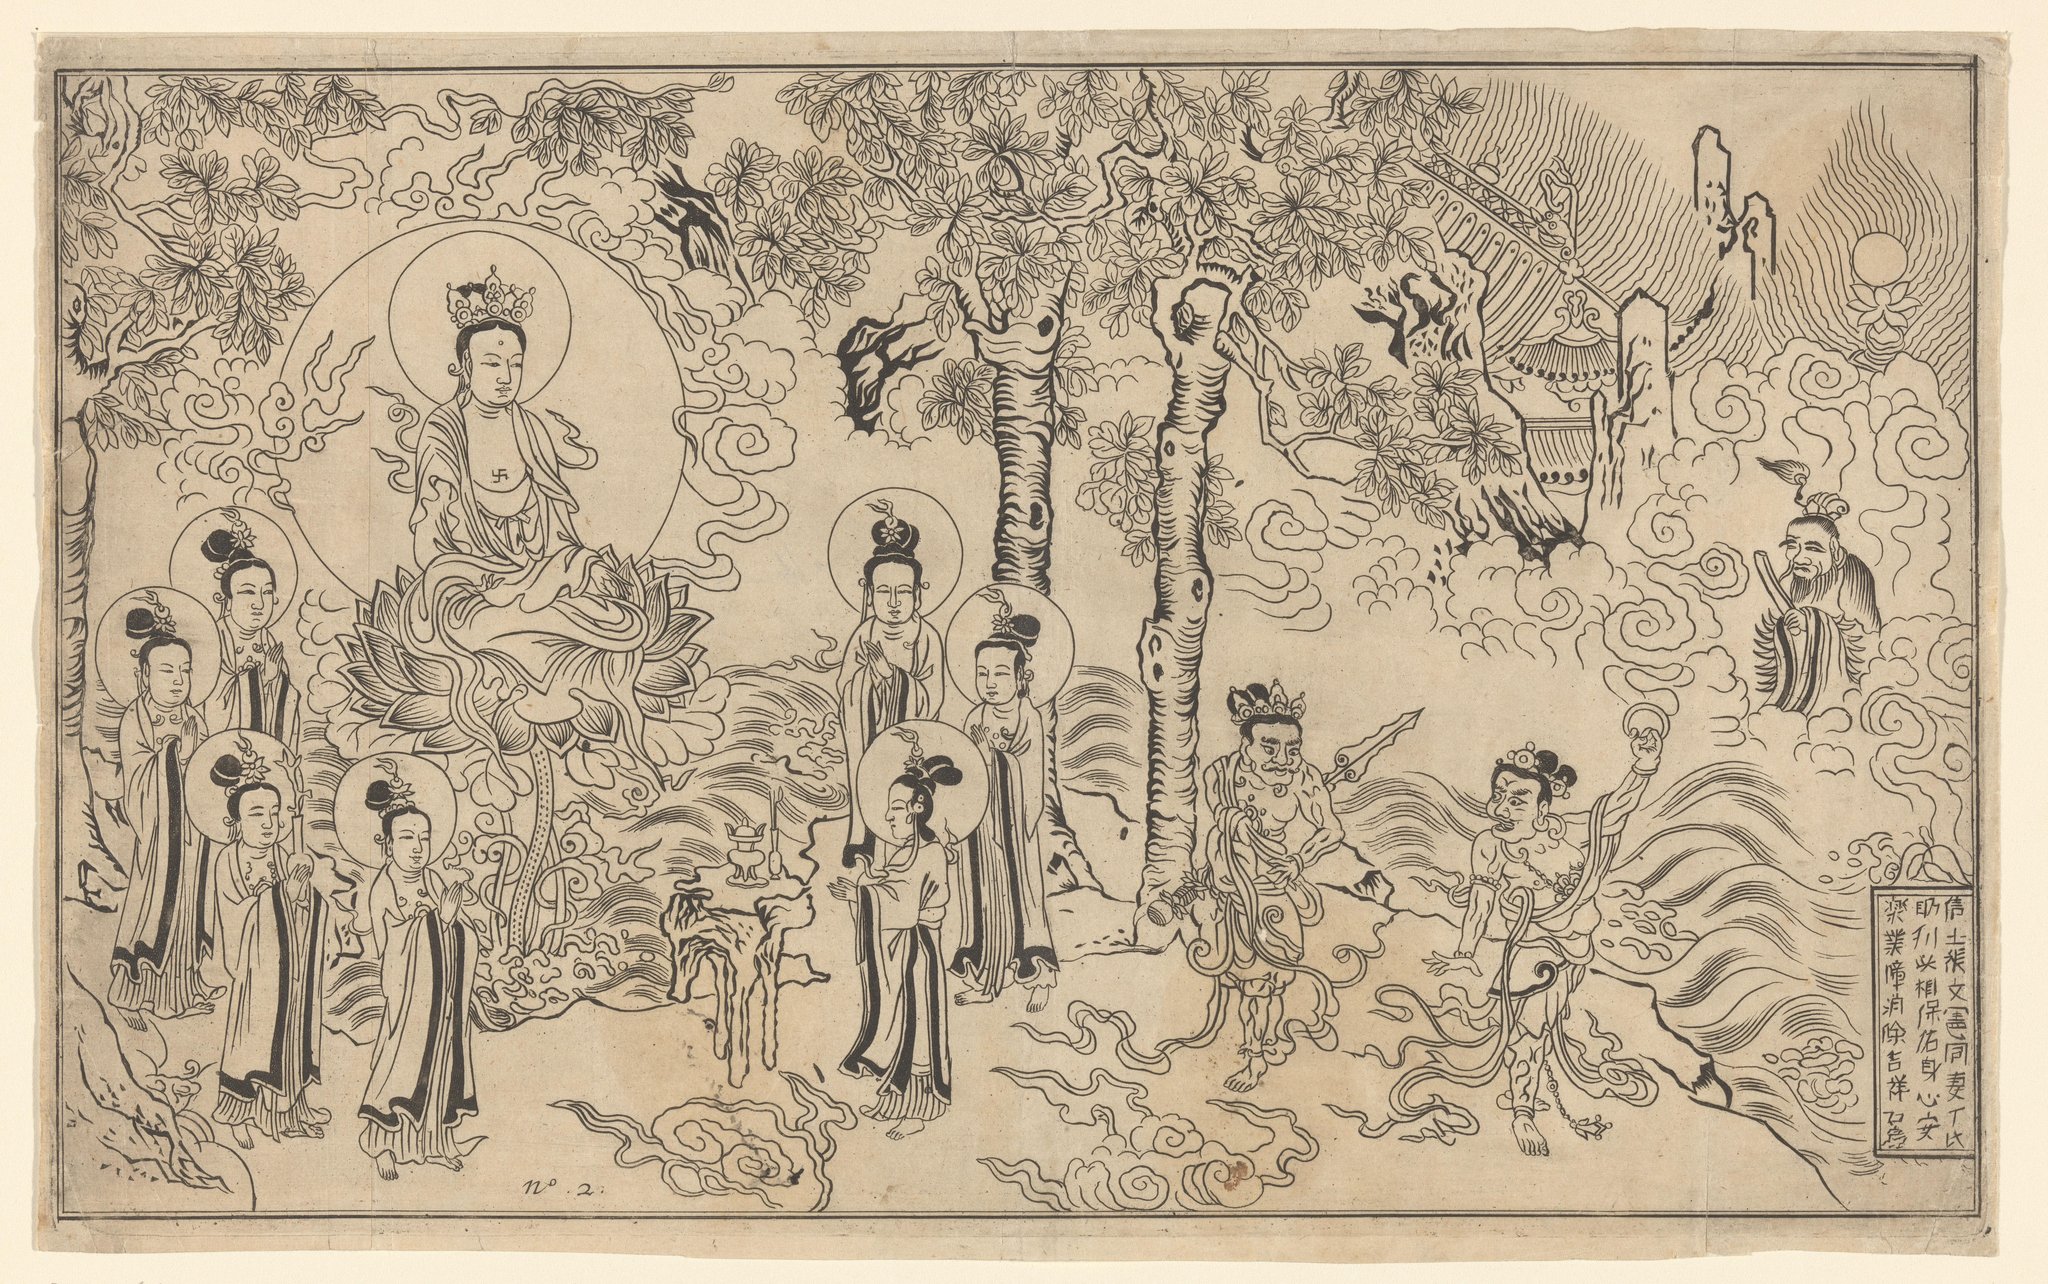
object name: print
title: Blad twee uit een reeks van vier bladen met Chinese voorstellingen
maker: Anonymous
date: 1670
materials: paper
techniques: engraving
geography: amsterdam